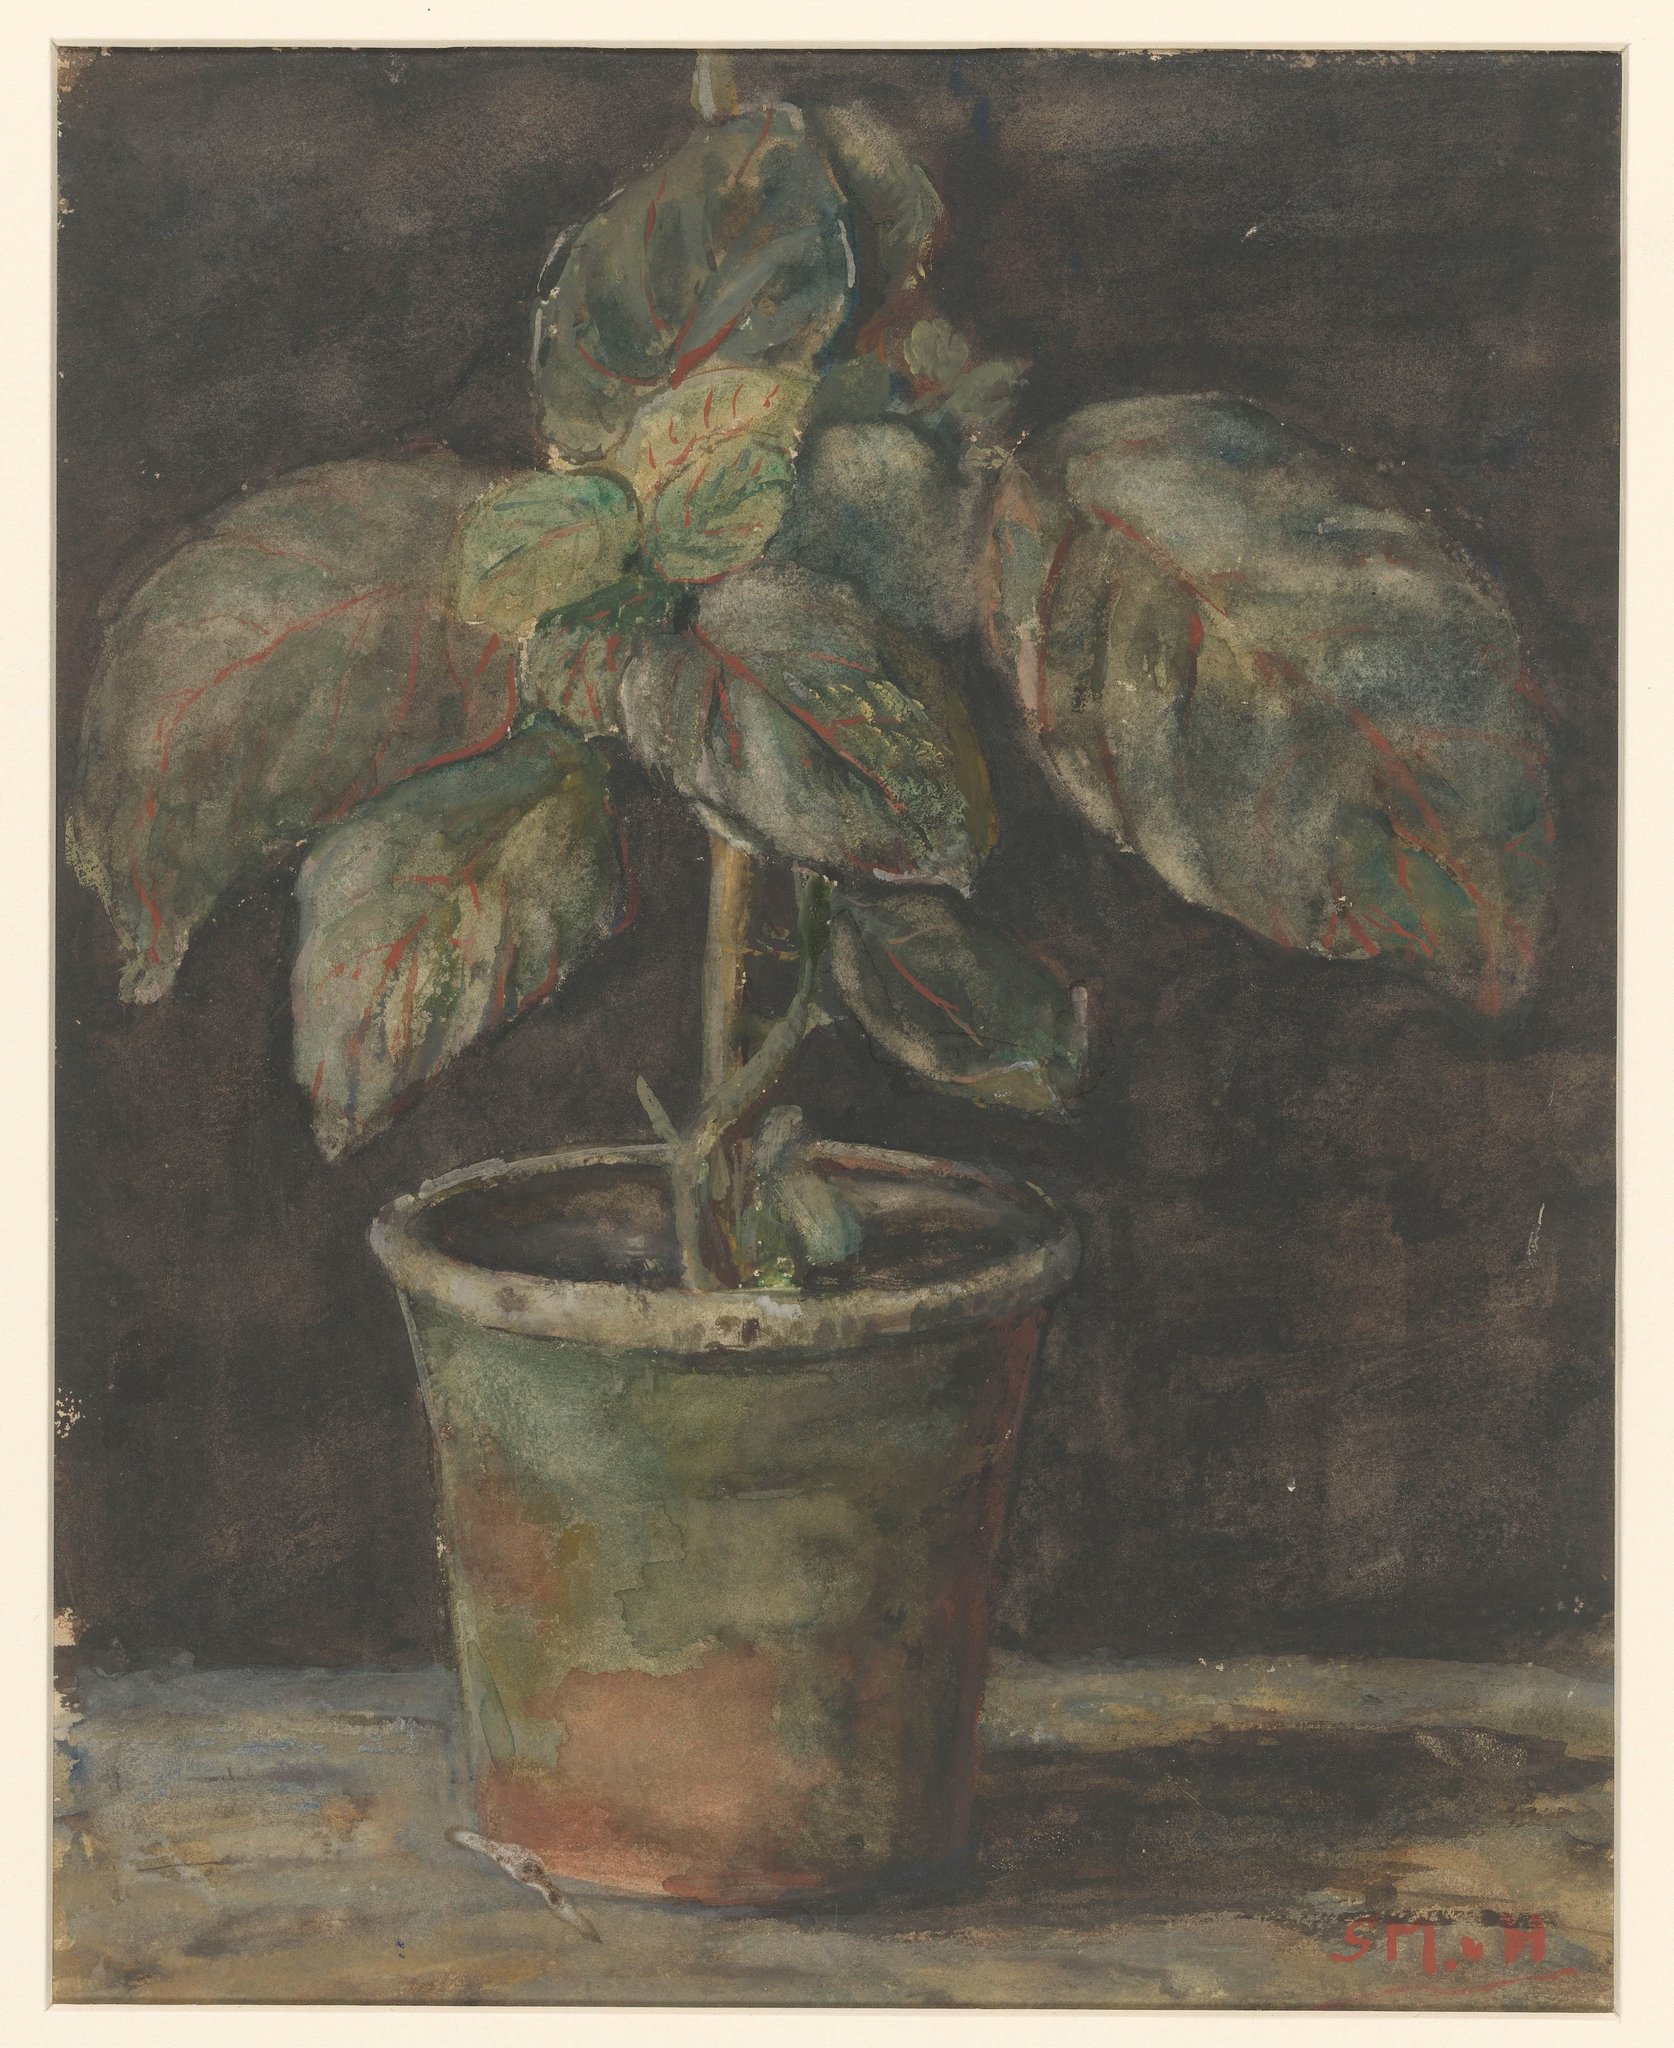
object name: drawing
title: Een potplant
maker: sientje mesdag-van houten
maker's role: draughtsman, painter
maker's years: 1834-1909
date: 1844-1909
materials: paper, watercolor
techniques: brush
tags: plants and herbs